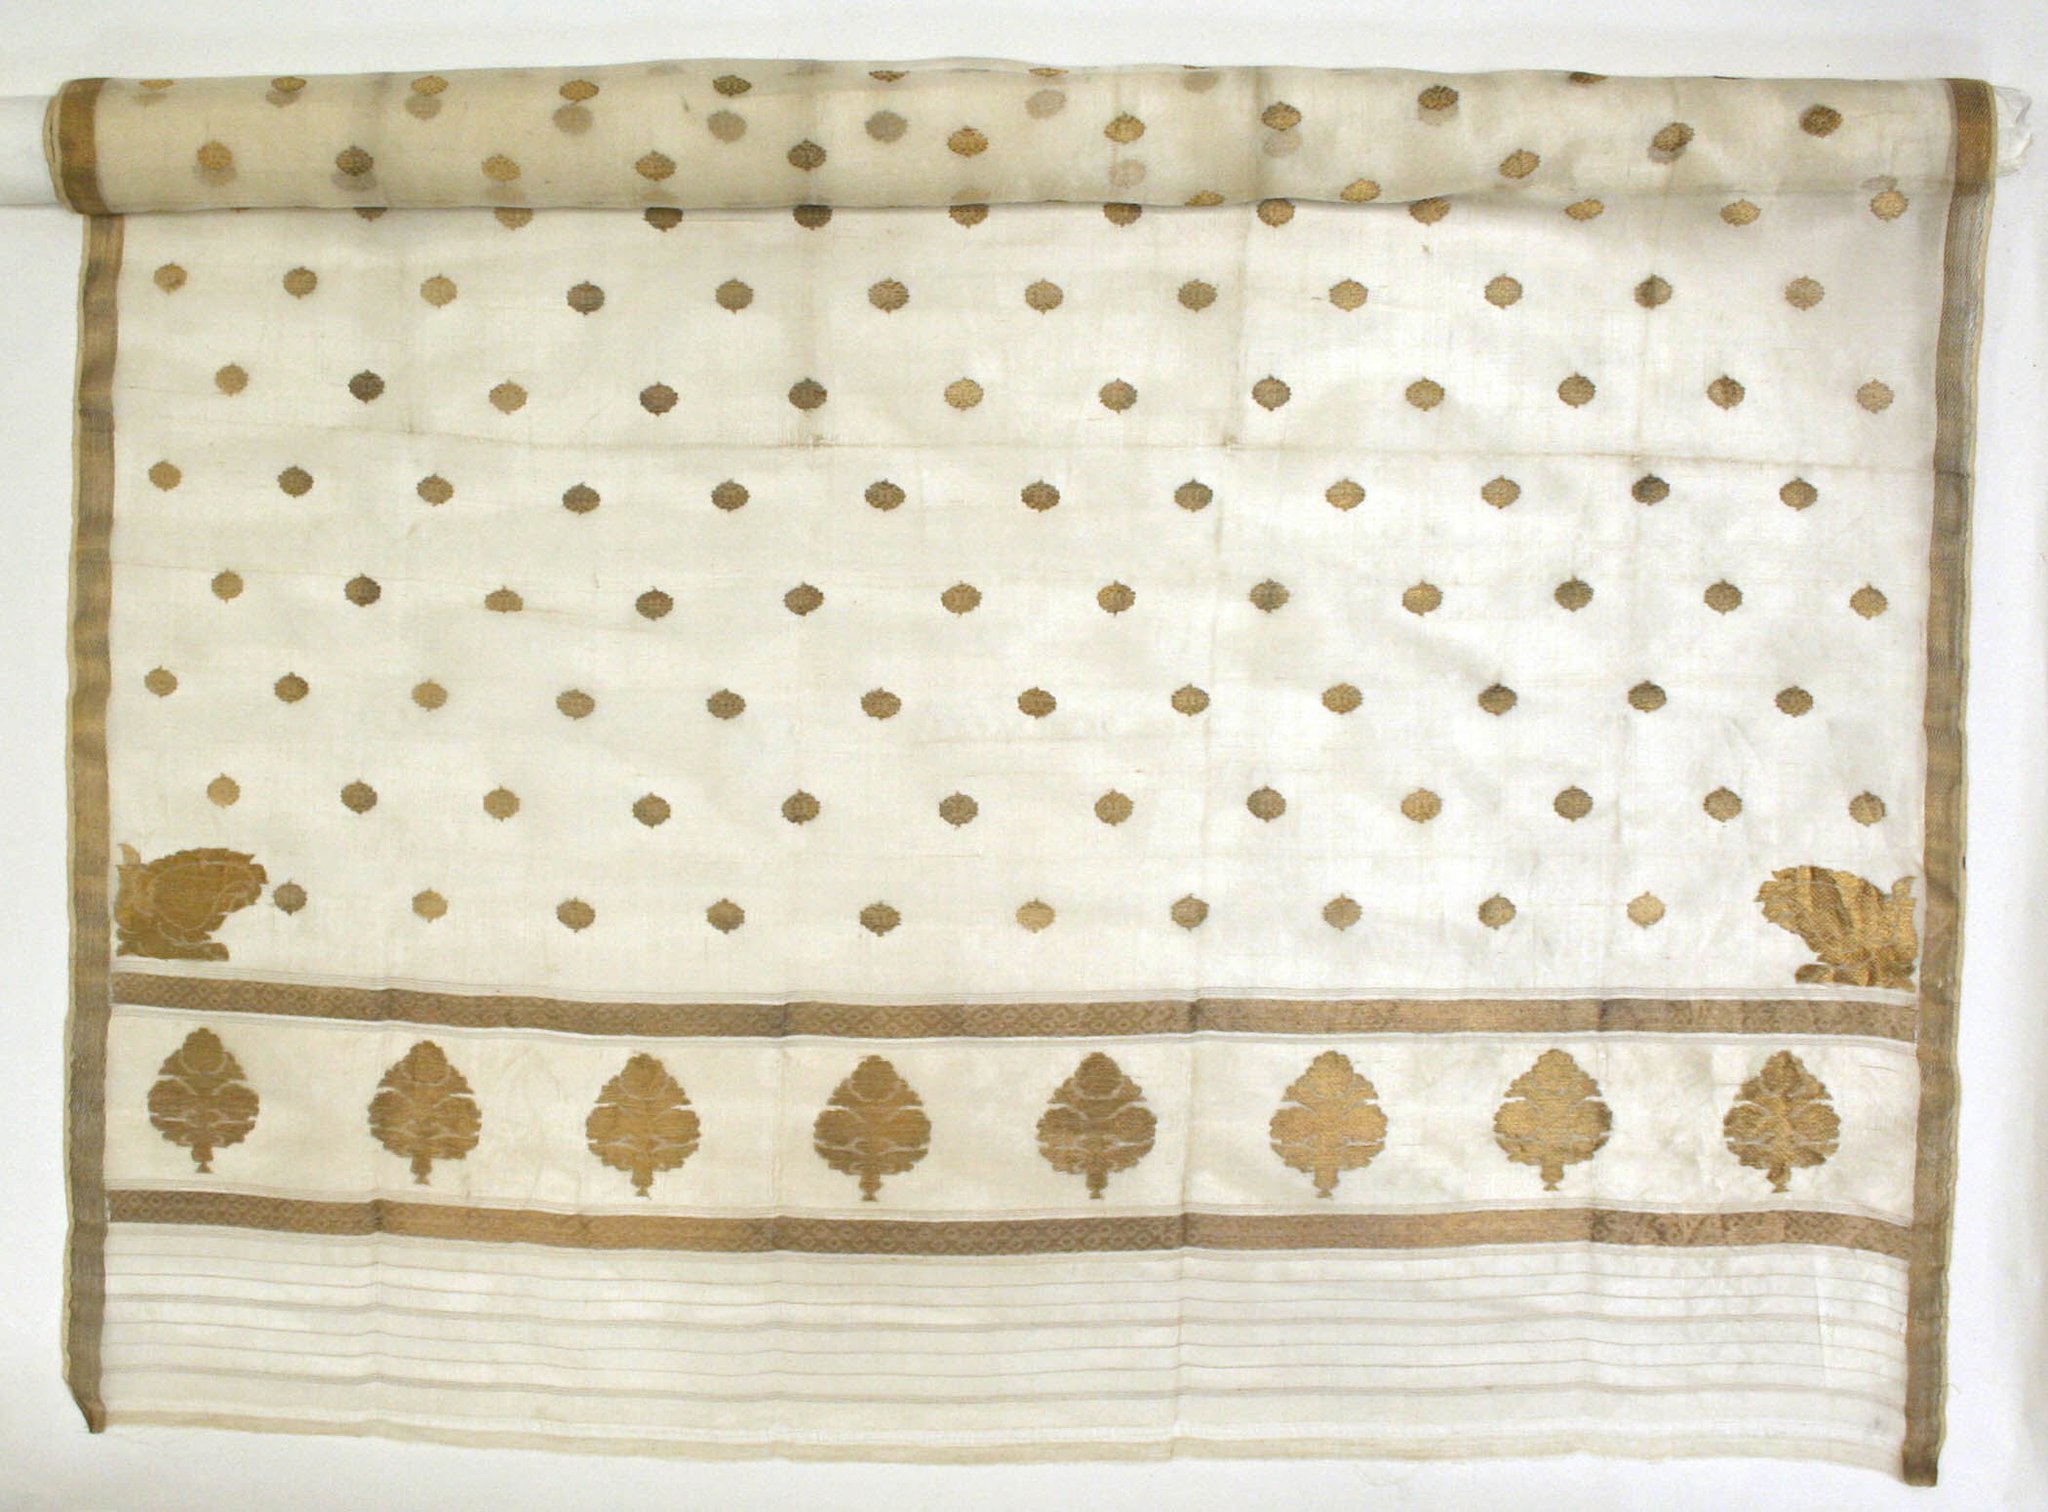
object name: sari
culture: indian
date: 1801-1900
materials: silk